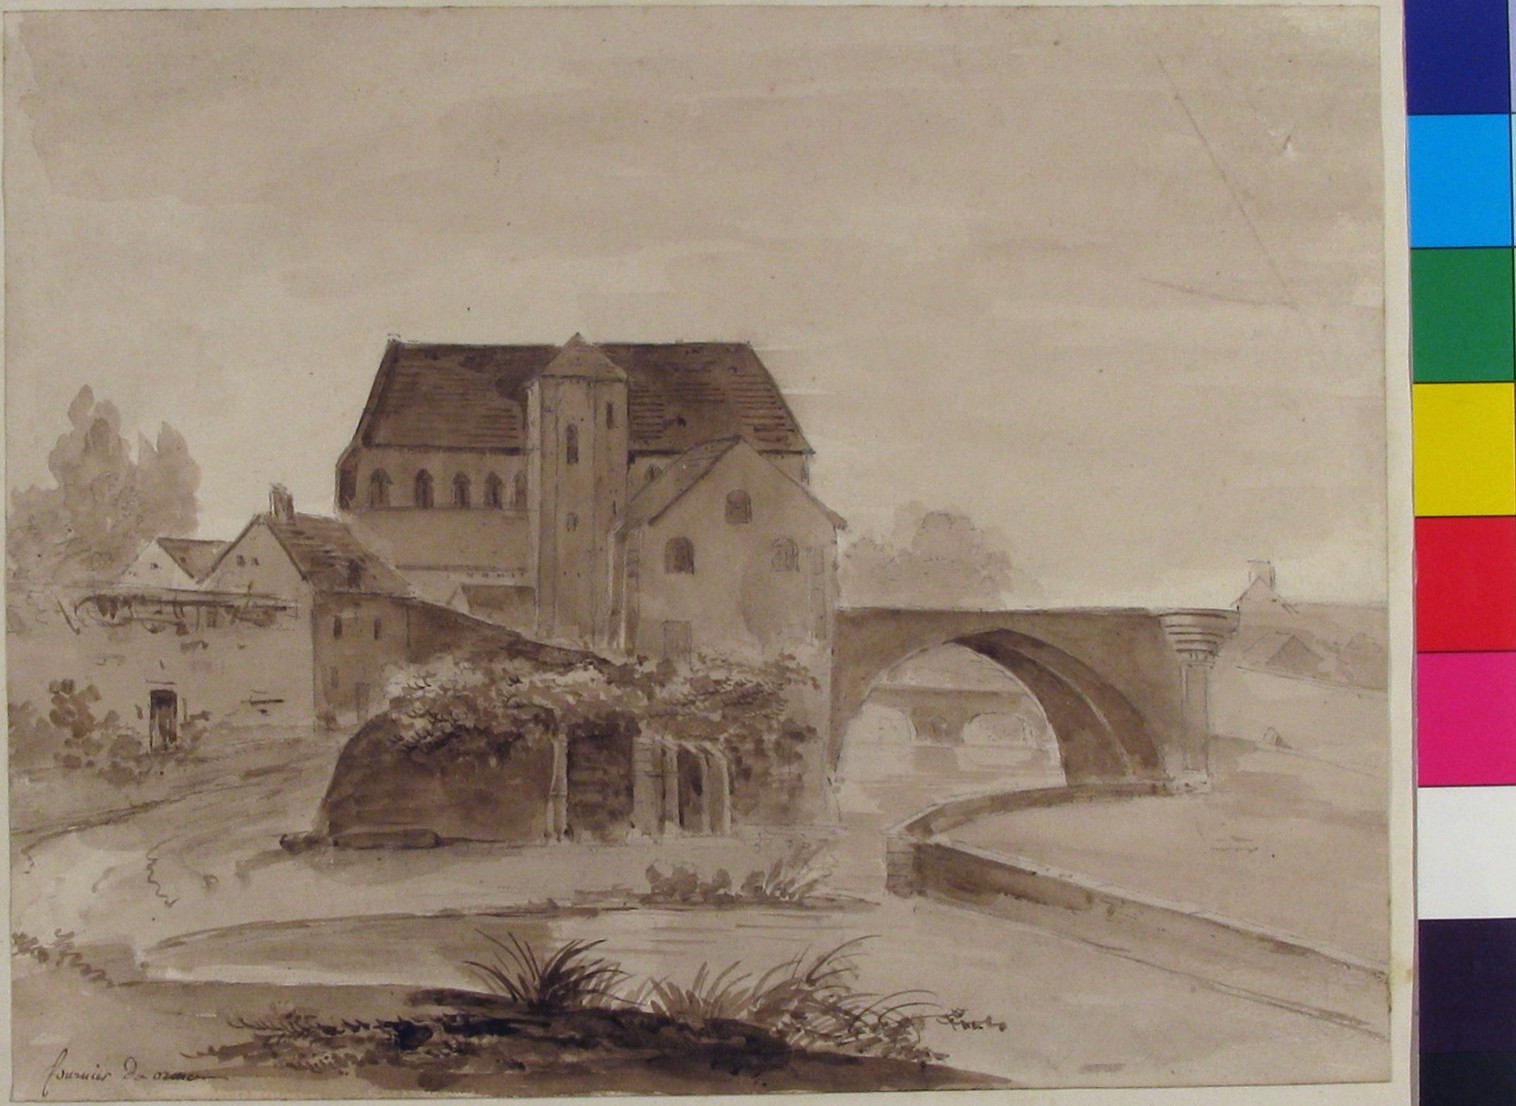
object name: drawing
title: Eglise St. André, Chartres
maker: charles fournier des ormes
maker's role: artist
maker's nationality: french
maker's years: 1777-1850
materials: graphite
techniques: brush, wash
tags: houses,churches